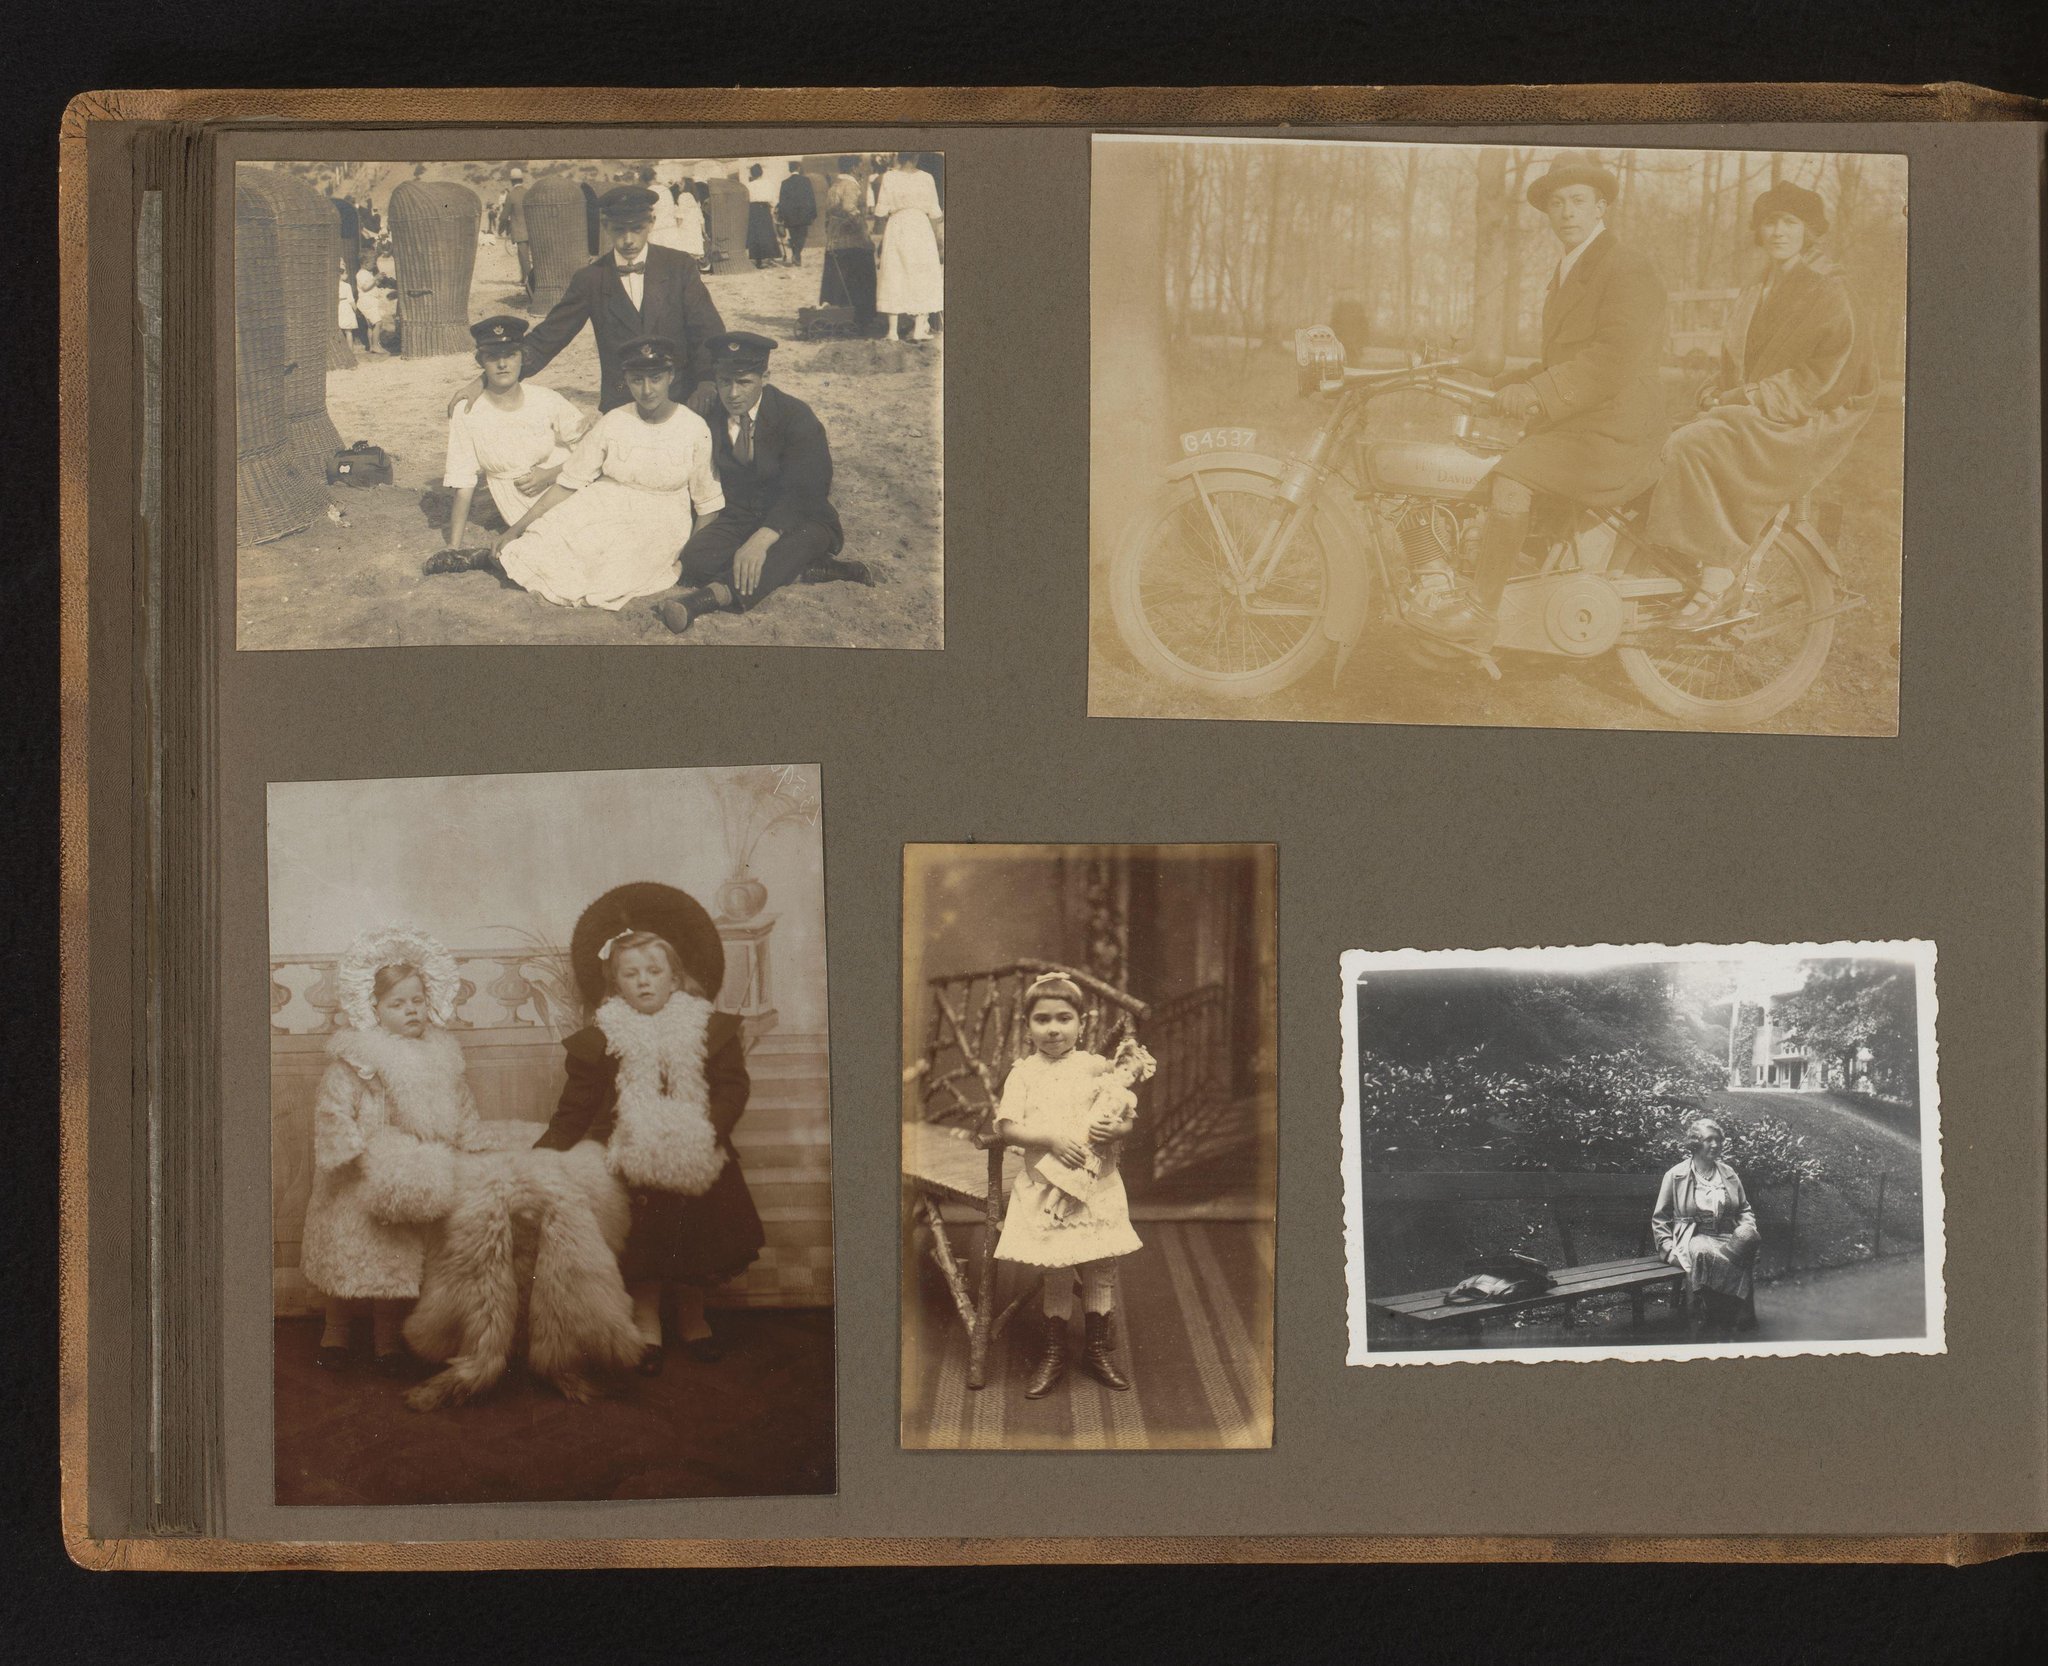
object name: album leaf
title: Portretten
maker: Anonymous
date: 1900-1950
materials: photographic support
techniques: albumen print, gelatin silver print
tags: adult woman, motor-cycles and other two-wheeled motor-vehicles, adult man, child, historical persons, (playing with) dolls, beach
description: Jonge mannen en vrouwen met petten op, op het strand, een man en vrouw op een motor, twee kinderen met een bont- of schapenvel, een meisje met een pop en een vrouw op een bank. Deze pagina maakt deel uit van een album.